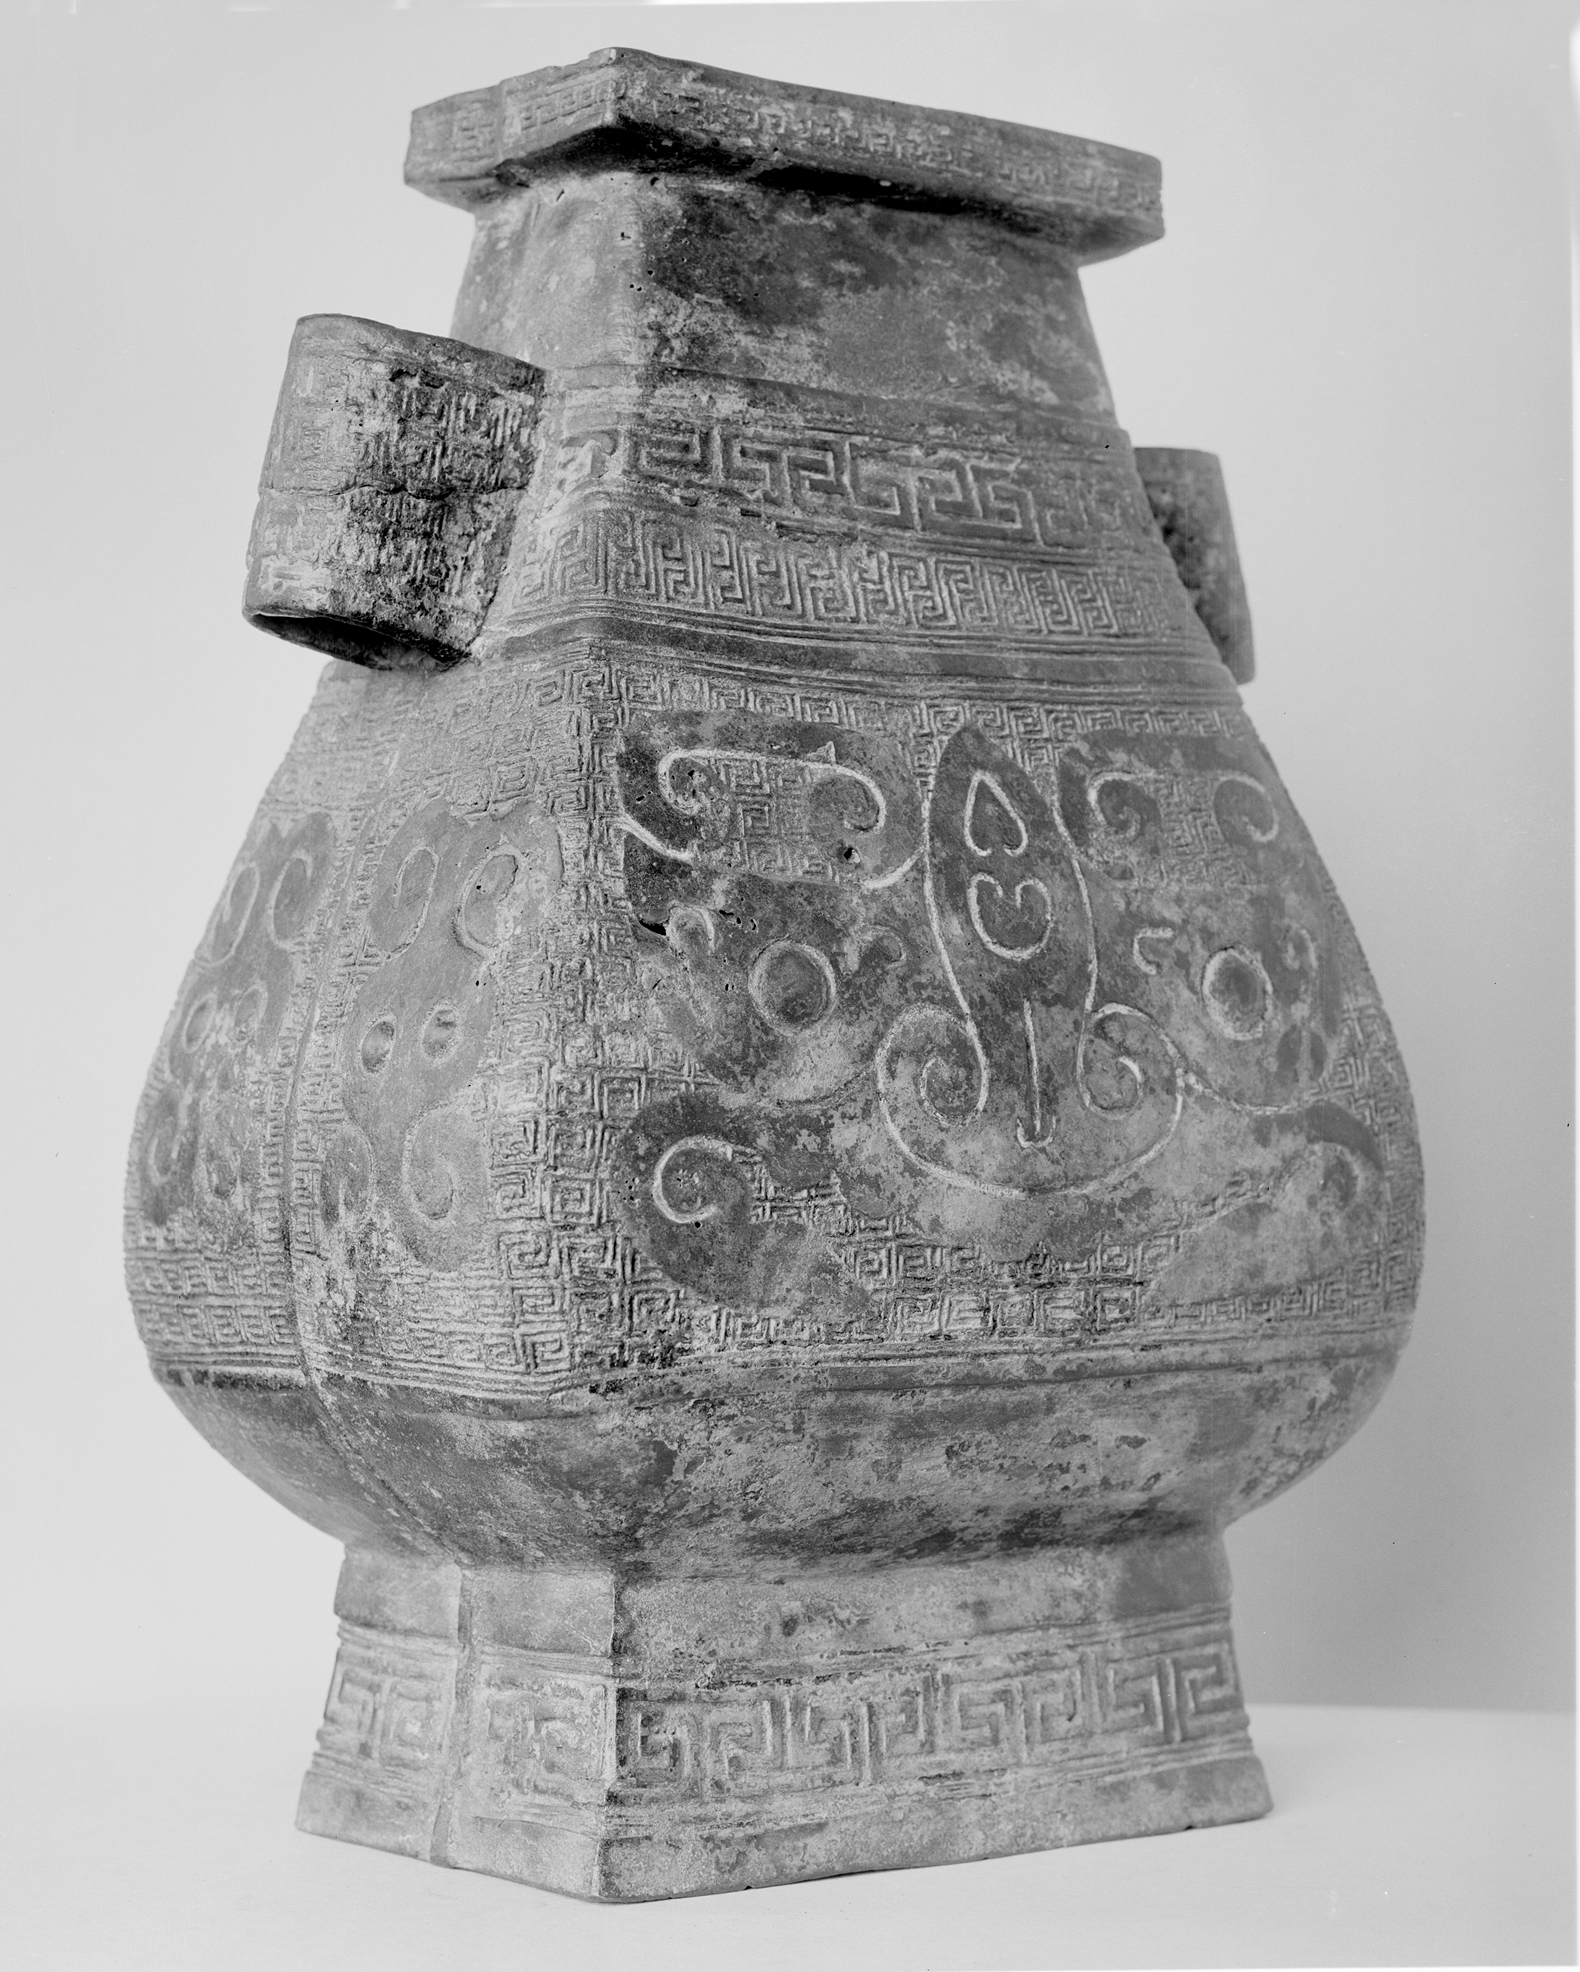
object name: vase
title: Vase of Zhou Design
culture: chinese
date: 960-1279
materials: bronze